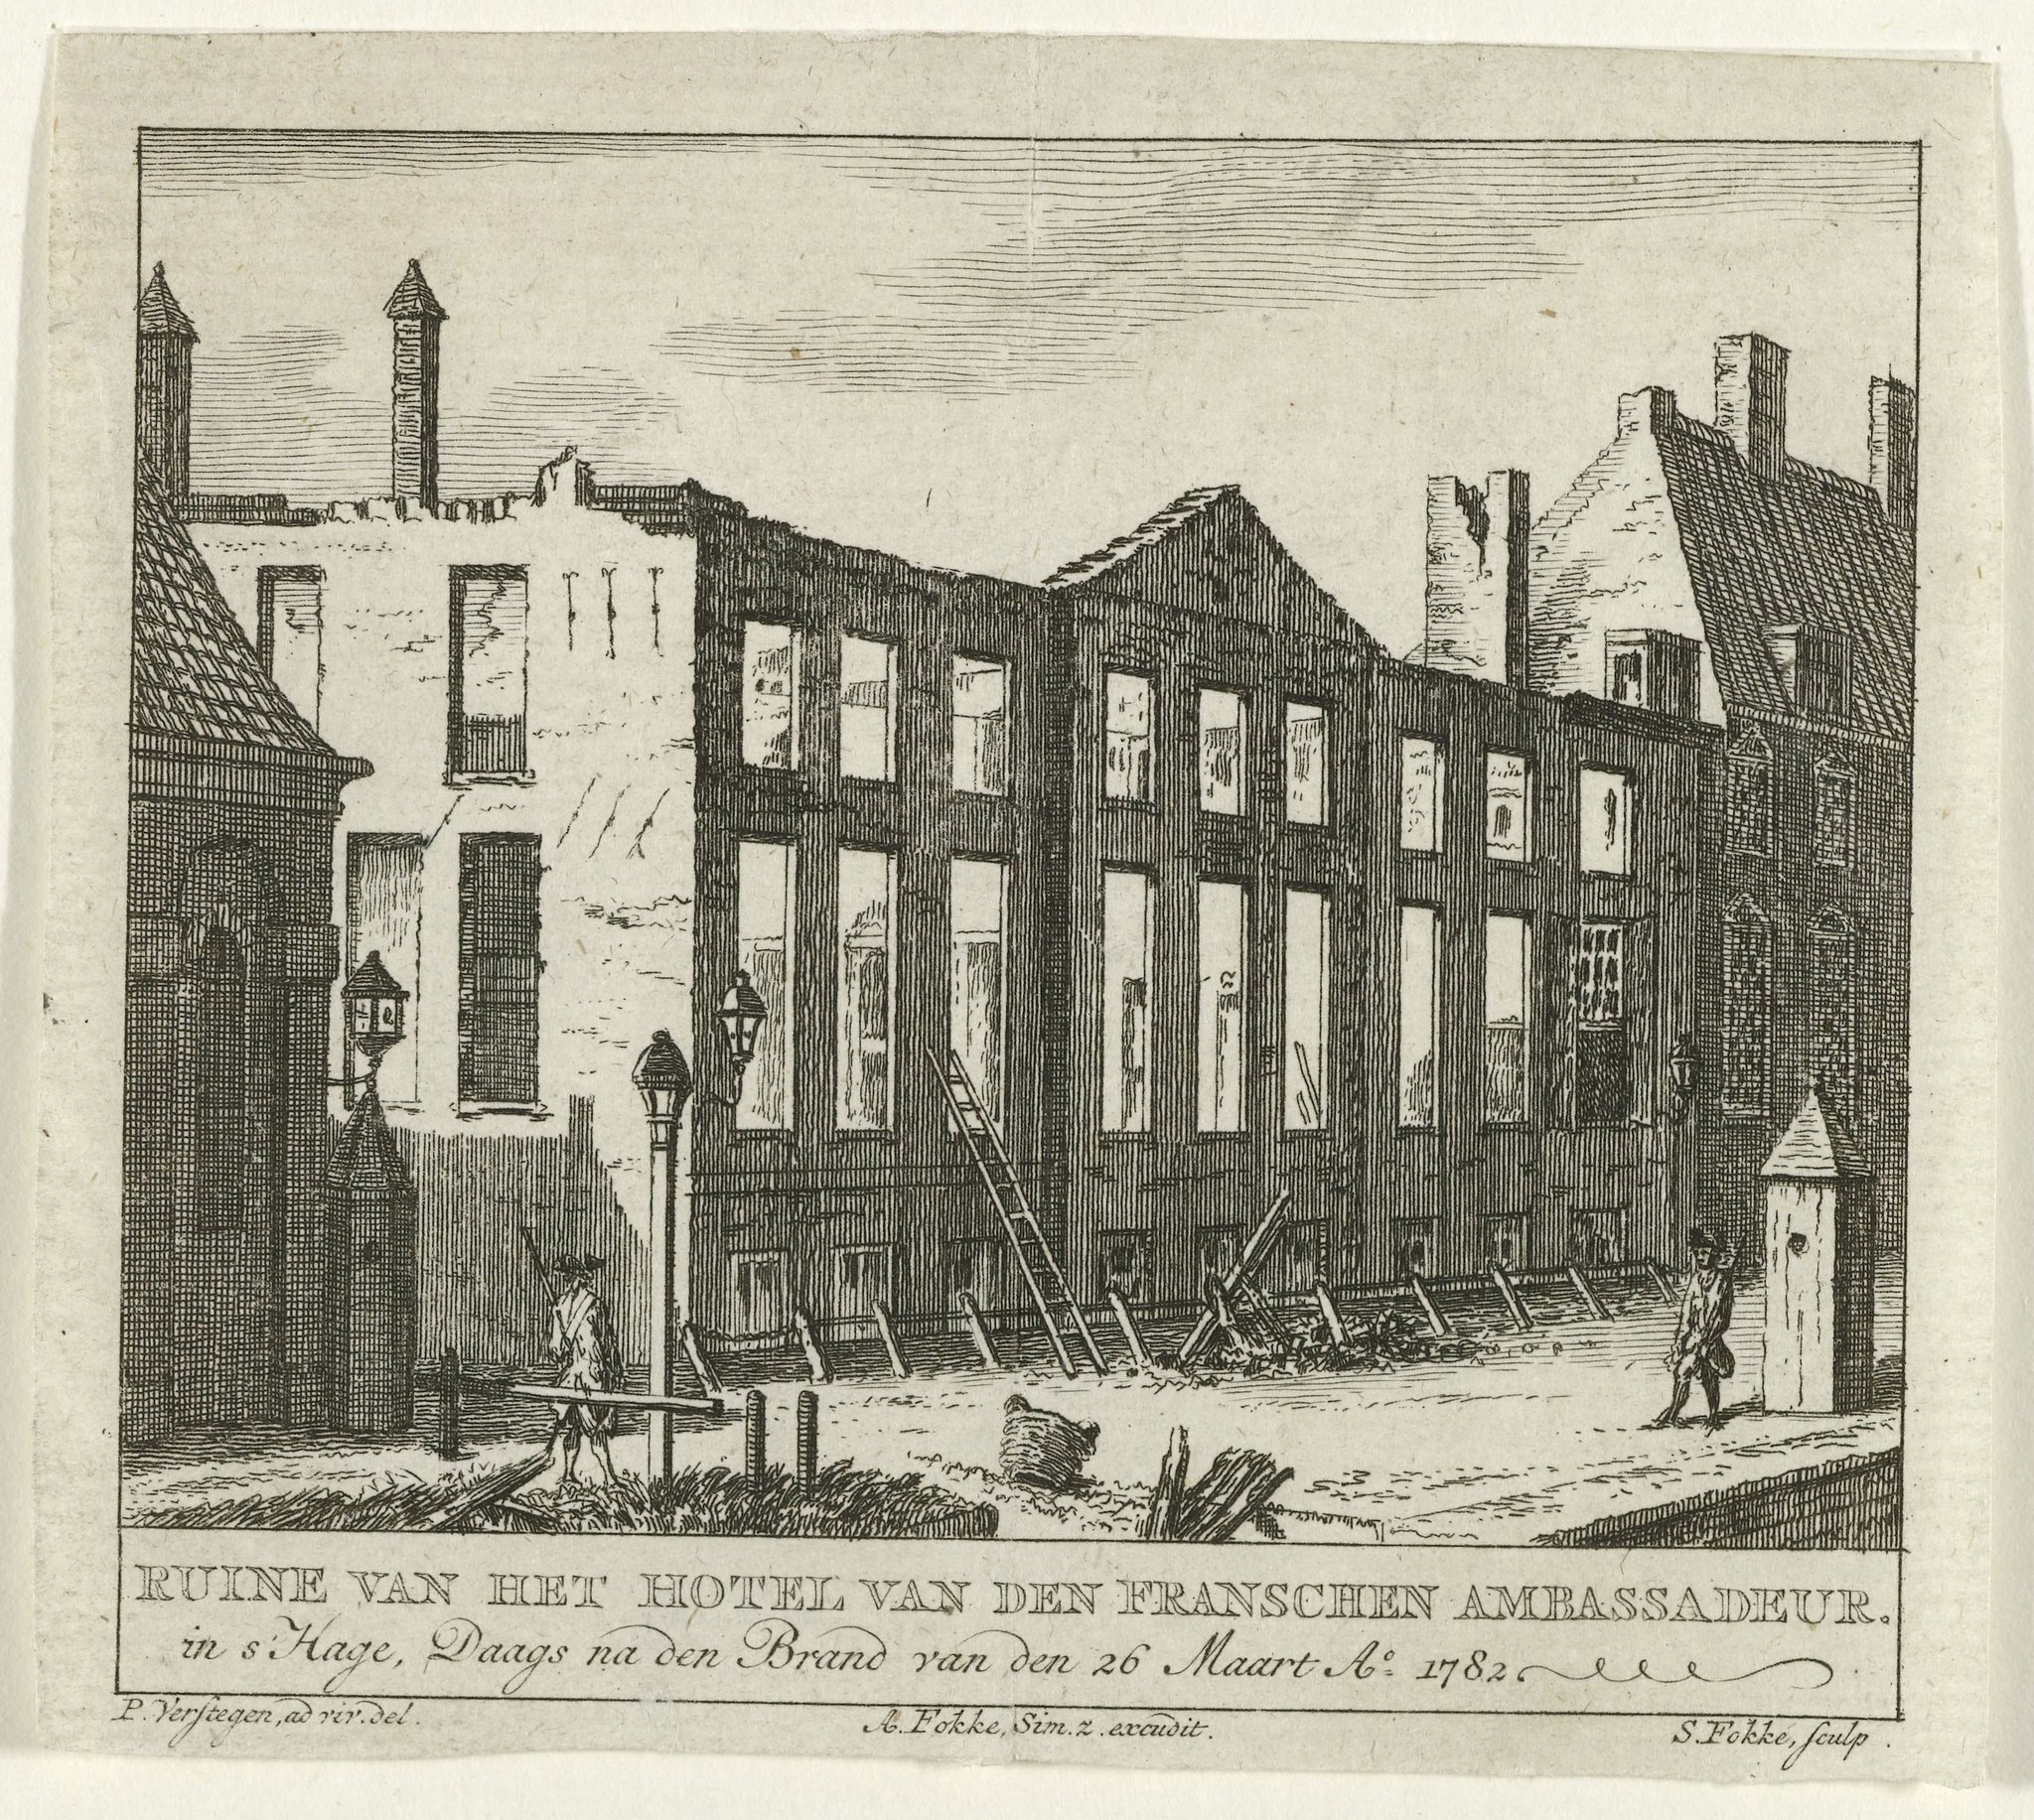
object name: print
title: Ruïne van het huis van de Franse ambassadeur in Den Haag, 1782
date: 1782-1784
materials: paper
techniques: engraving, etching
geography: northern netherlands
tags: ruin of a dwelling, house, castle, etc., the hague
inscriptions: collector's mark: Lugt 2228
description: Gebruikt als illustratie in: Arend Fokke Simonsz. De vaderlandsche historie in themata. Amsterdam: Arend Fokke Simonsz., edities tussen 1783-ca. 1792.